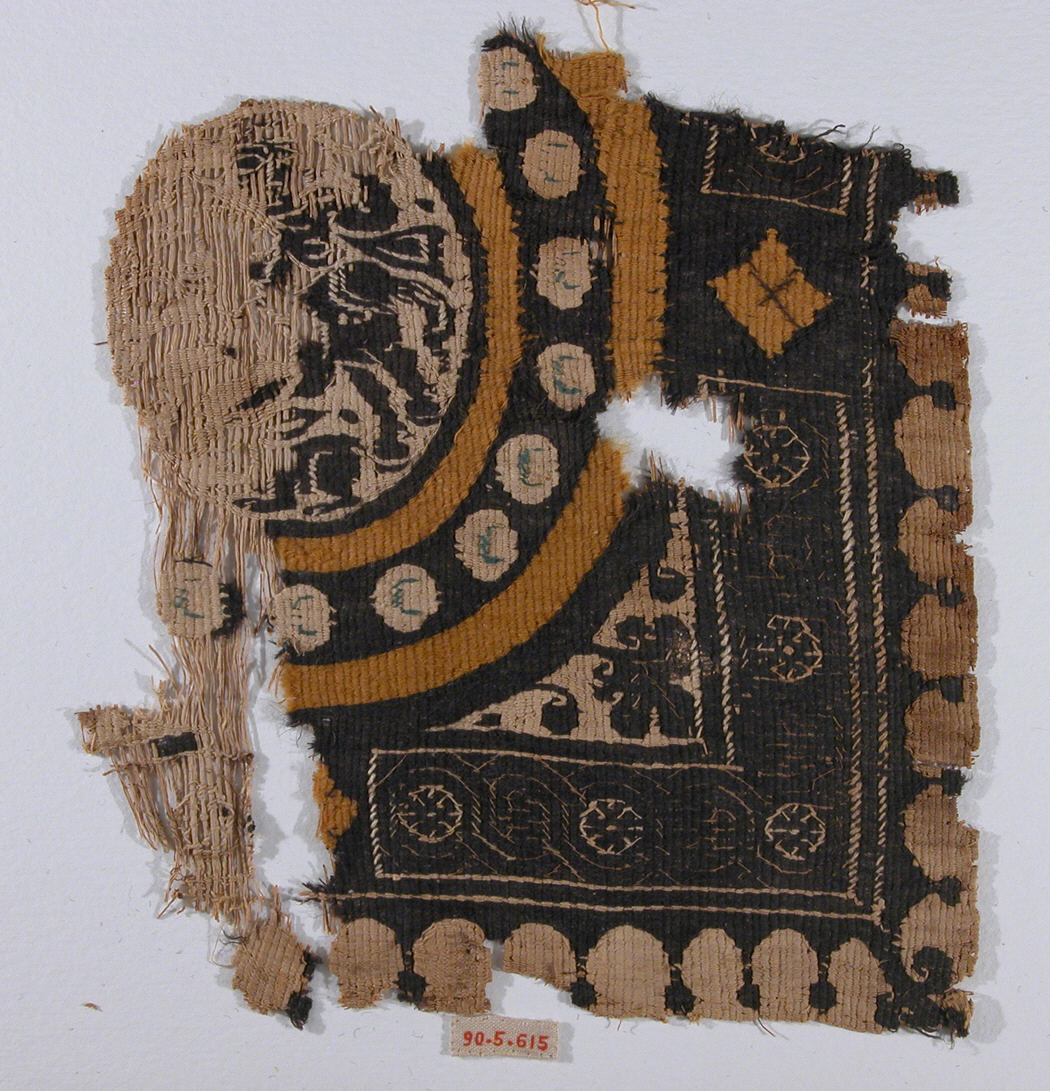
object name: textile fragment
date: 301-400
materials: linen, wool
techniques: weave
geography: egypt